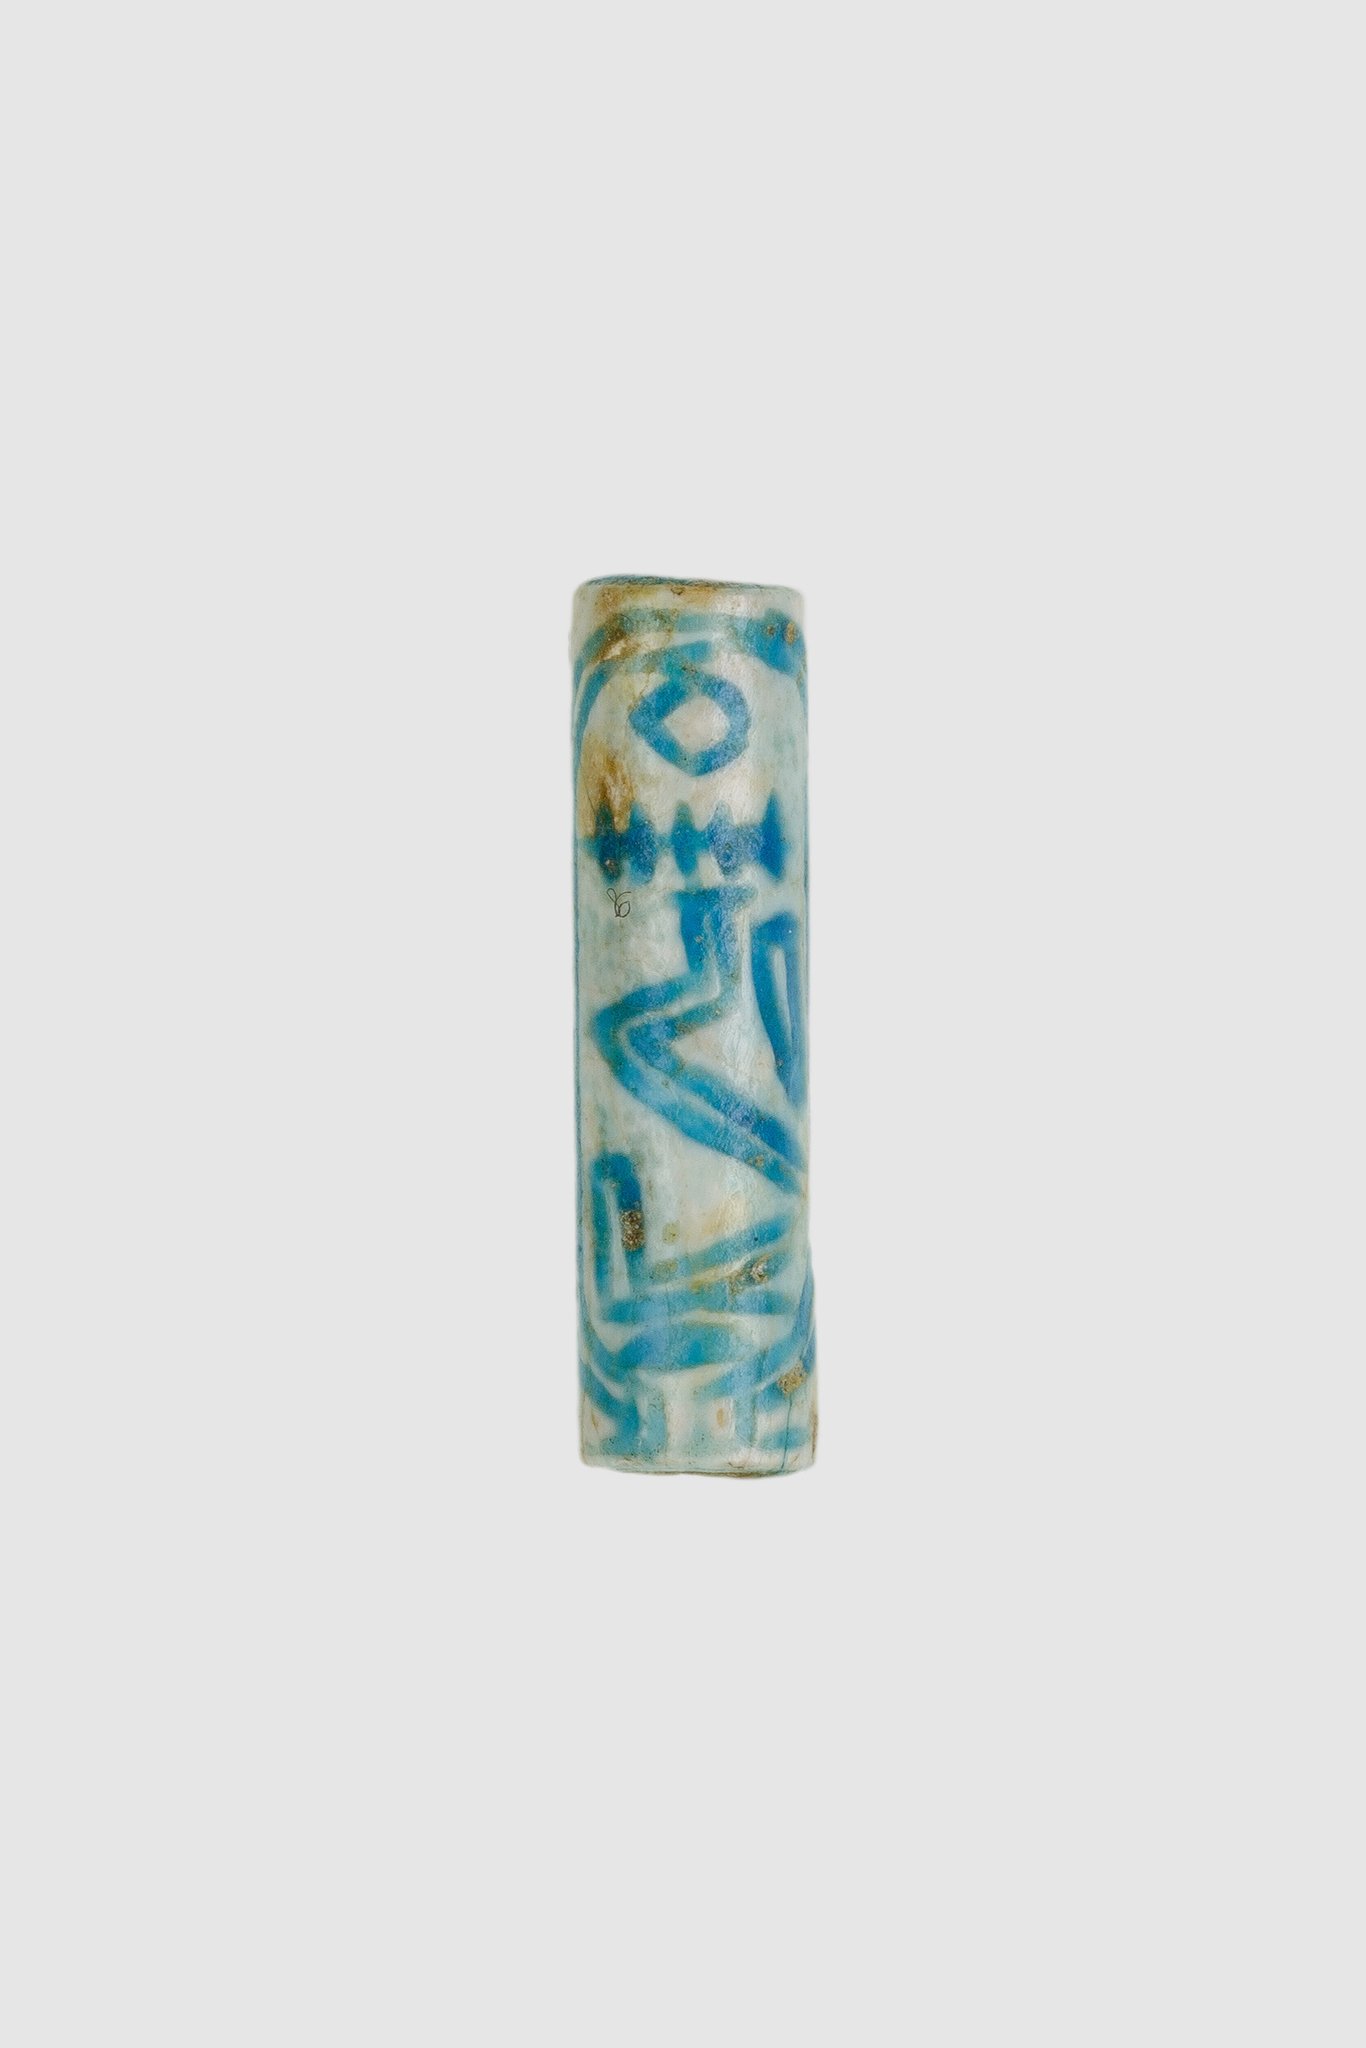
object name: cylinder seal, amenemhat iii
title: Cylinder seal with name of Amenemhat III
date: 1981-1640 BCE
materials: stone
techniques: glazing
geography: egypt